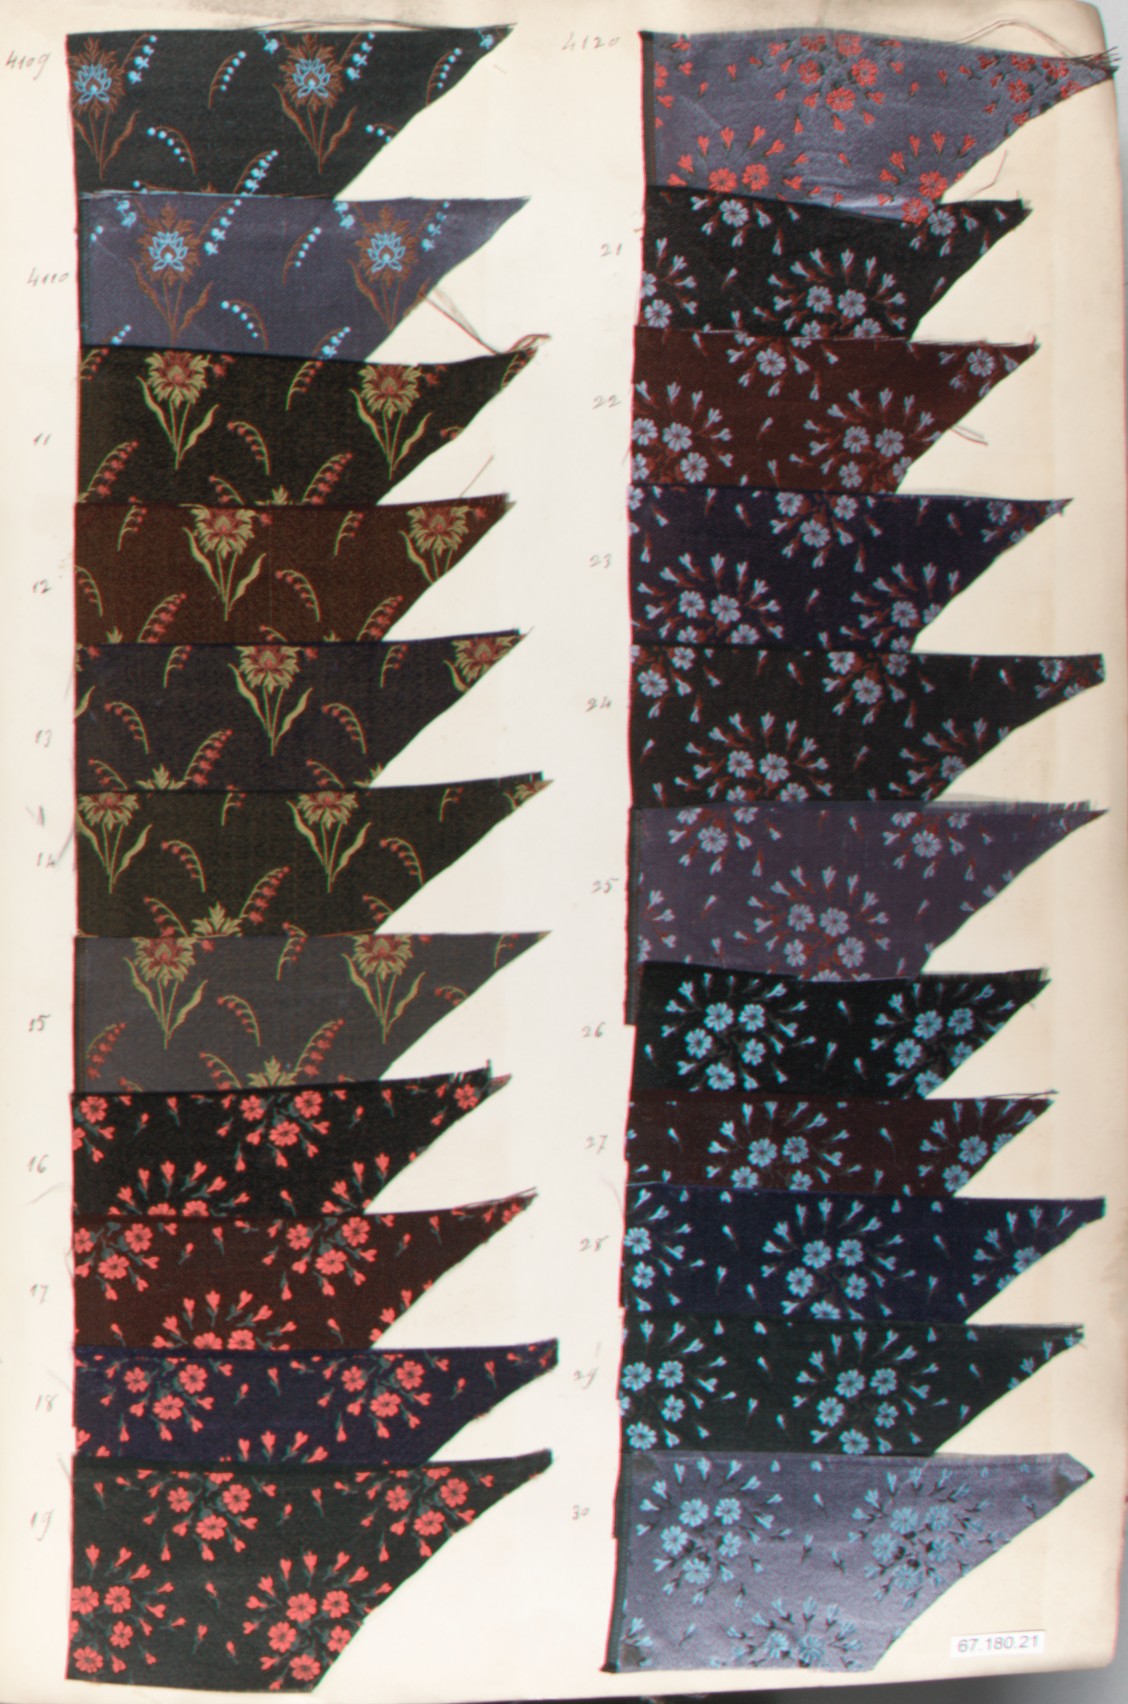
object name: sample book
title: Textile Sample Book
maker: fabrique de registres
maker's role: manufactory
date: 1890-1899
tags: flowers